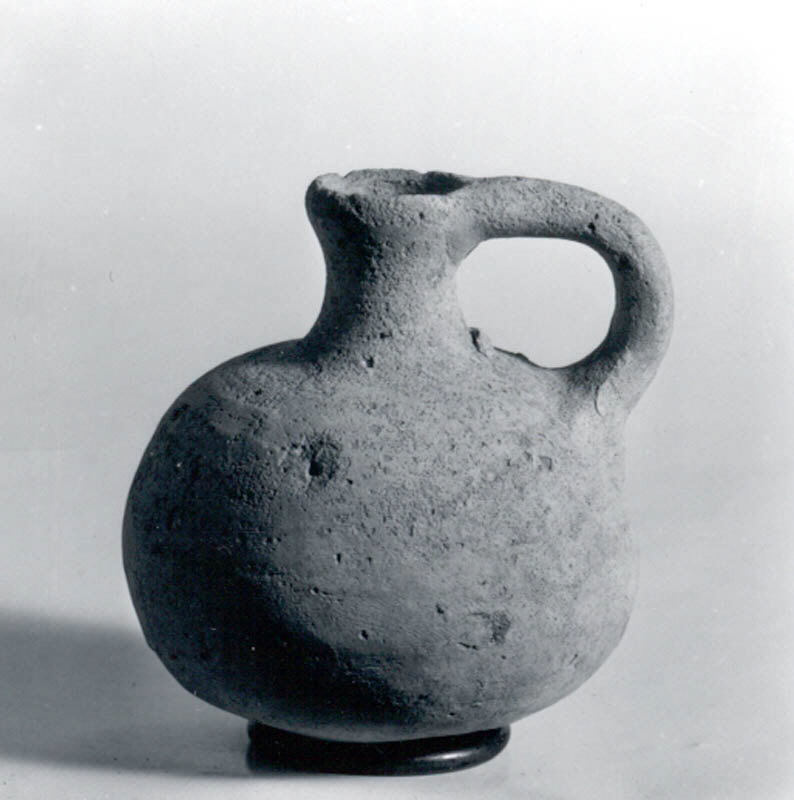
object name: jug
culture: israelite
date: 734-601 BCE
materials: ceramic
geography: levant